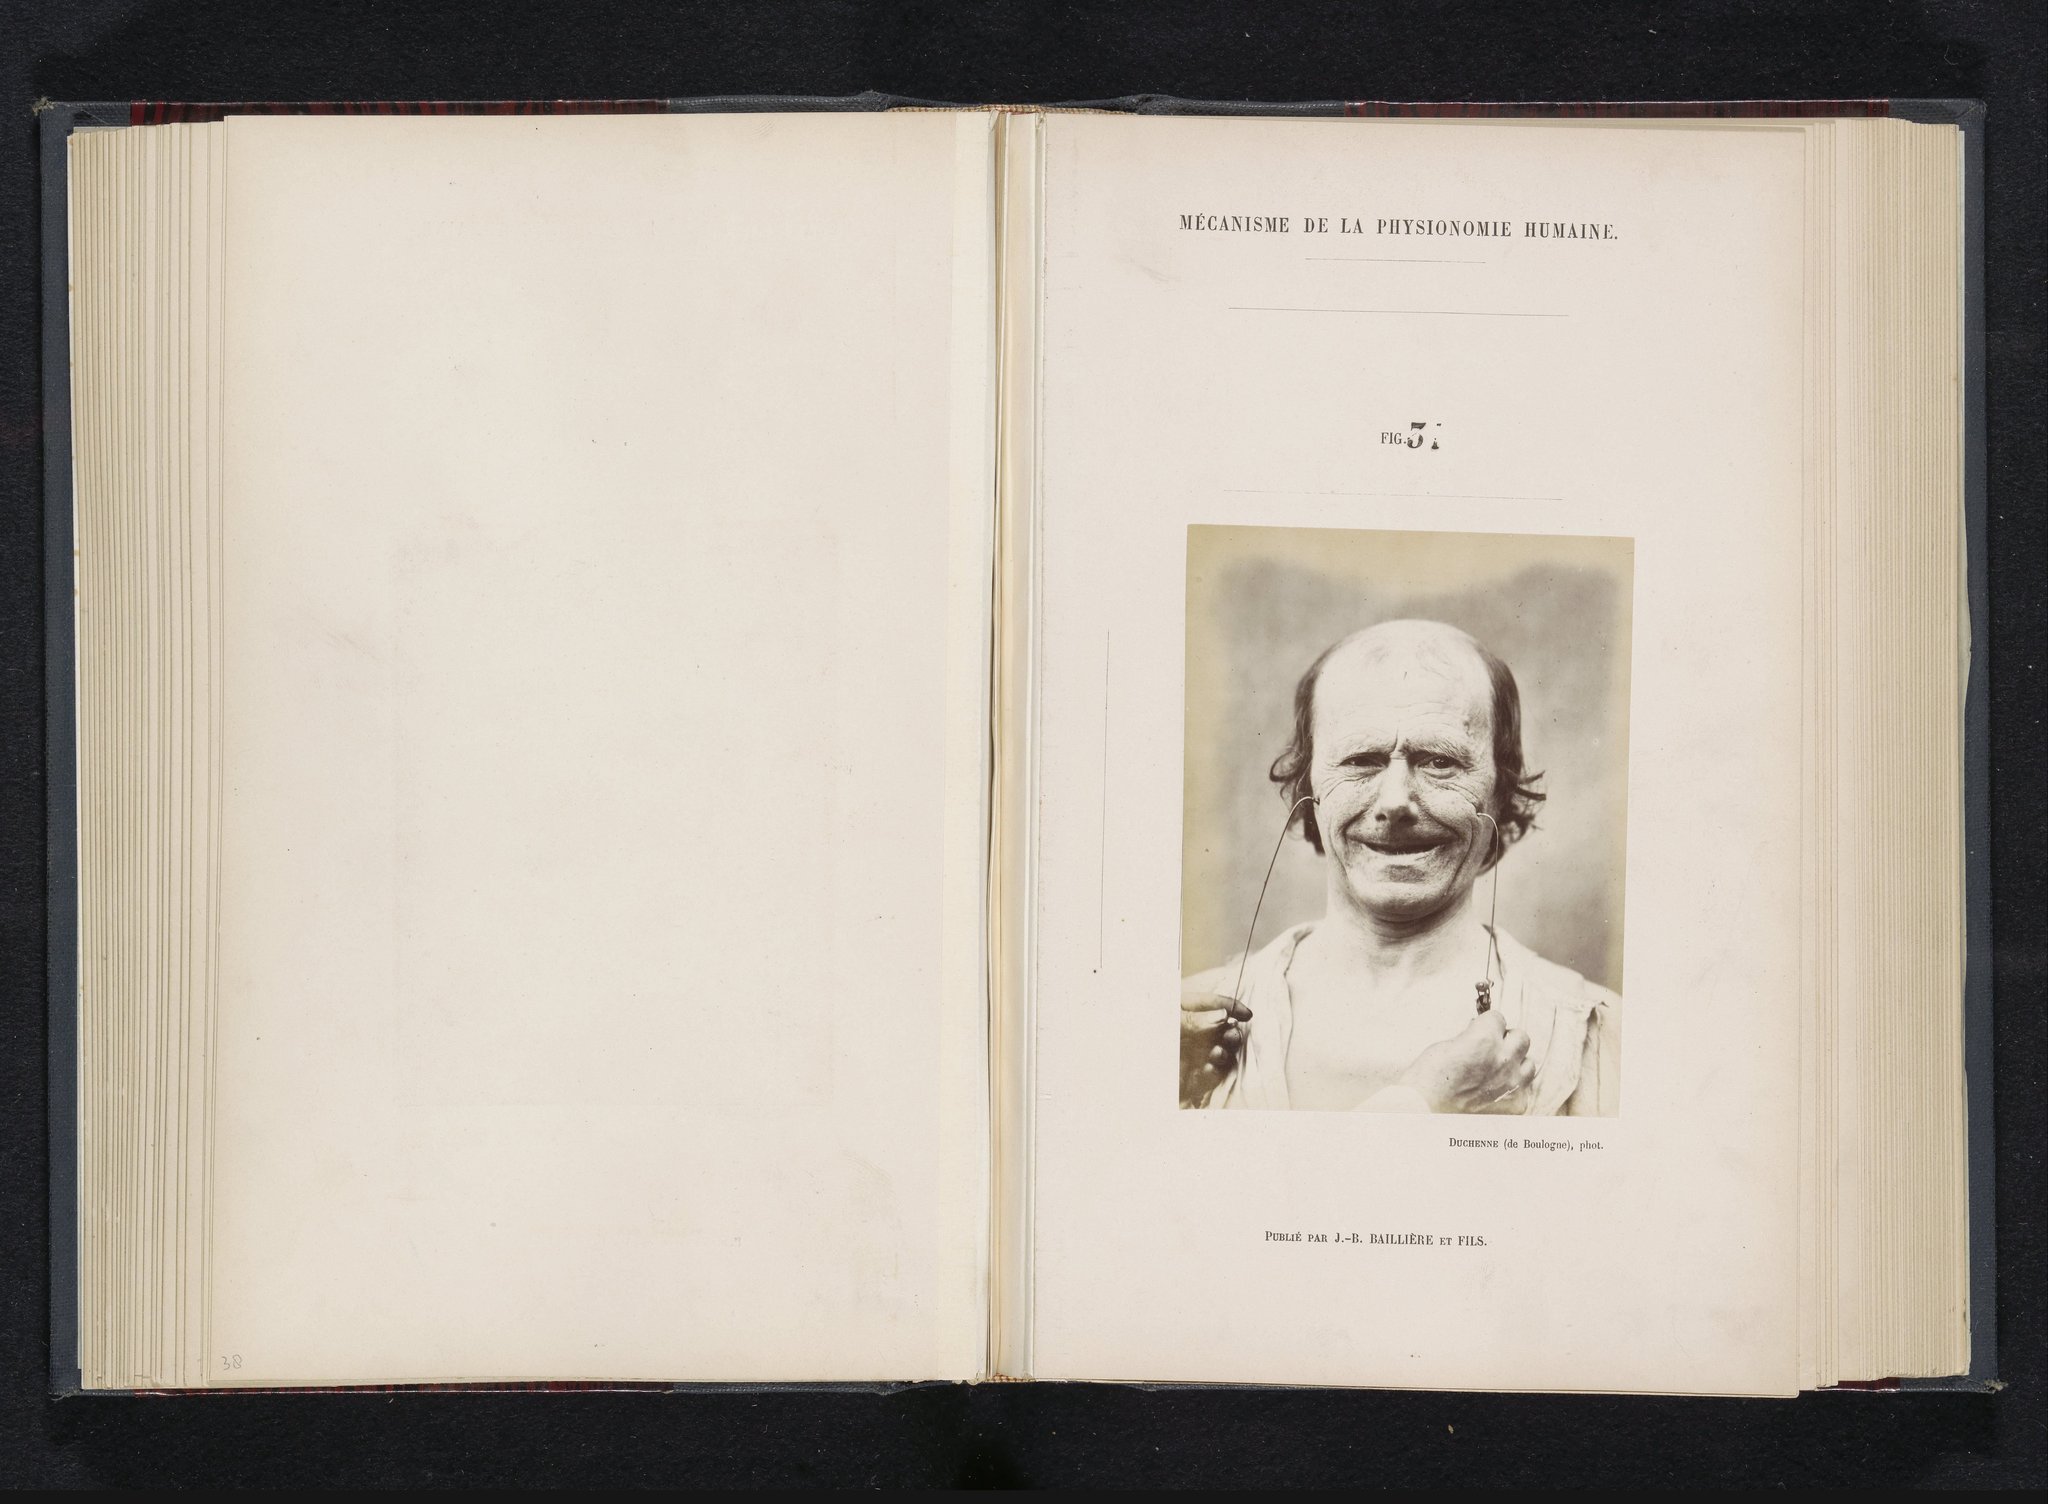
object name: page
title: Portret van een proefpersoon tijdens elektrostimulatie: 'un vieillard'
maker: guillaume benjamin amand duchenne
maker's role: fotograaf, medicus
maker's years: 1806-1875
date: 1860-1862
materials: paper, photographic support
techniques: albumen print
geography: france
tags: face, physiology and anatomy ~ nervous system, neurology, physiology and anatomy, old man, morphology of facial expression, physiognomy, experiment, test ~ science and technology, france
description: Ongenummerde pagina met foto 31 uit Mécanisme de la physionomie humaine ou analyse électro-physiologique de l'expression des passions (Atlas).